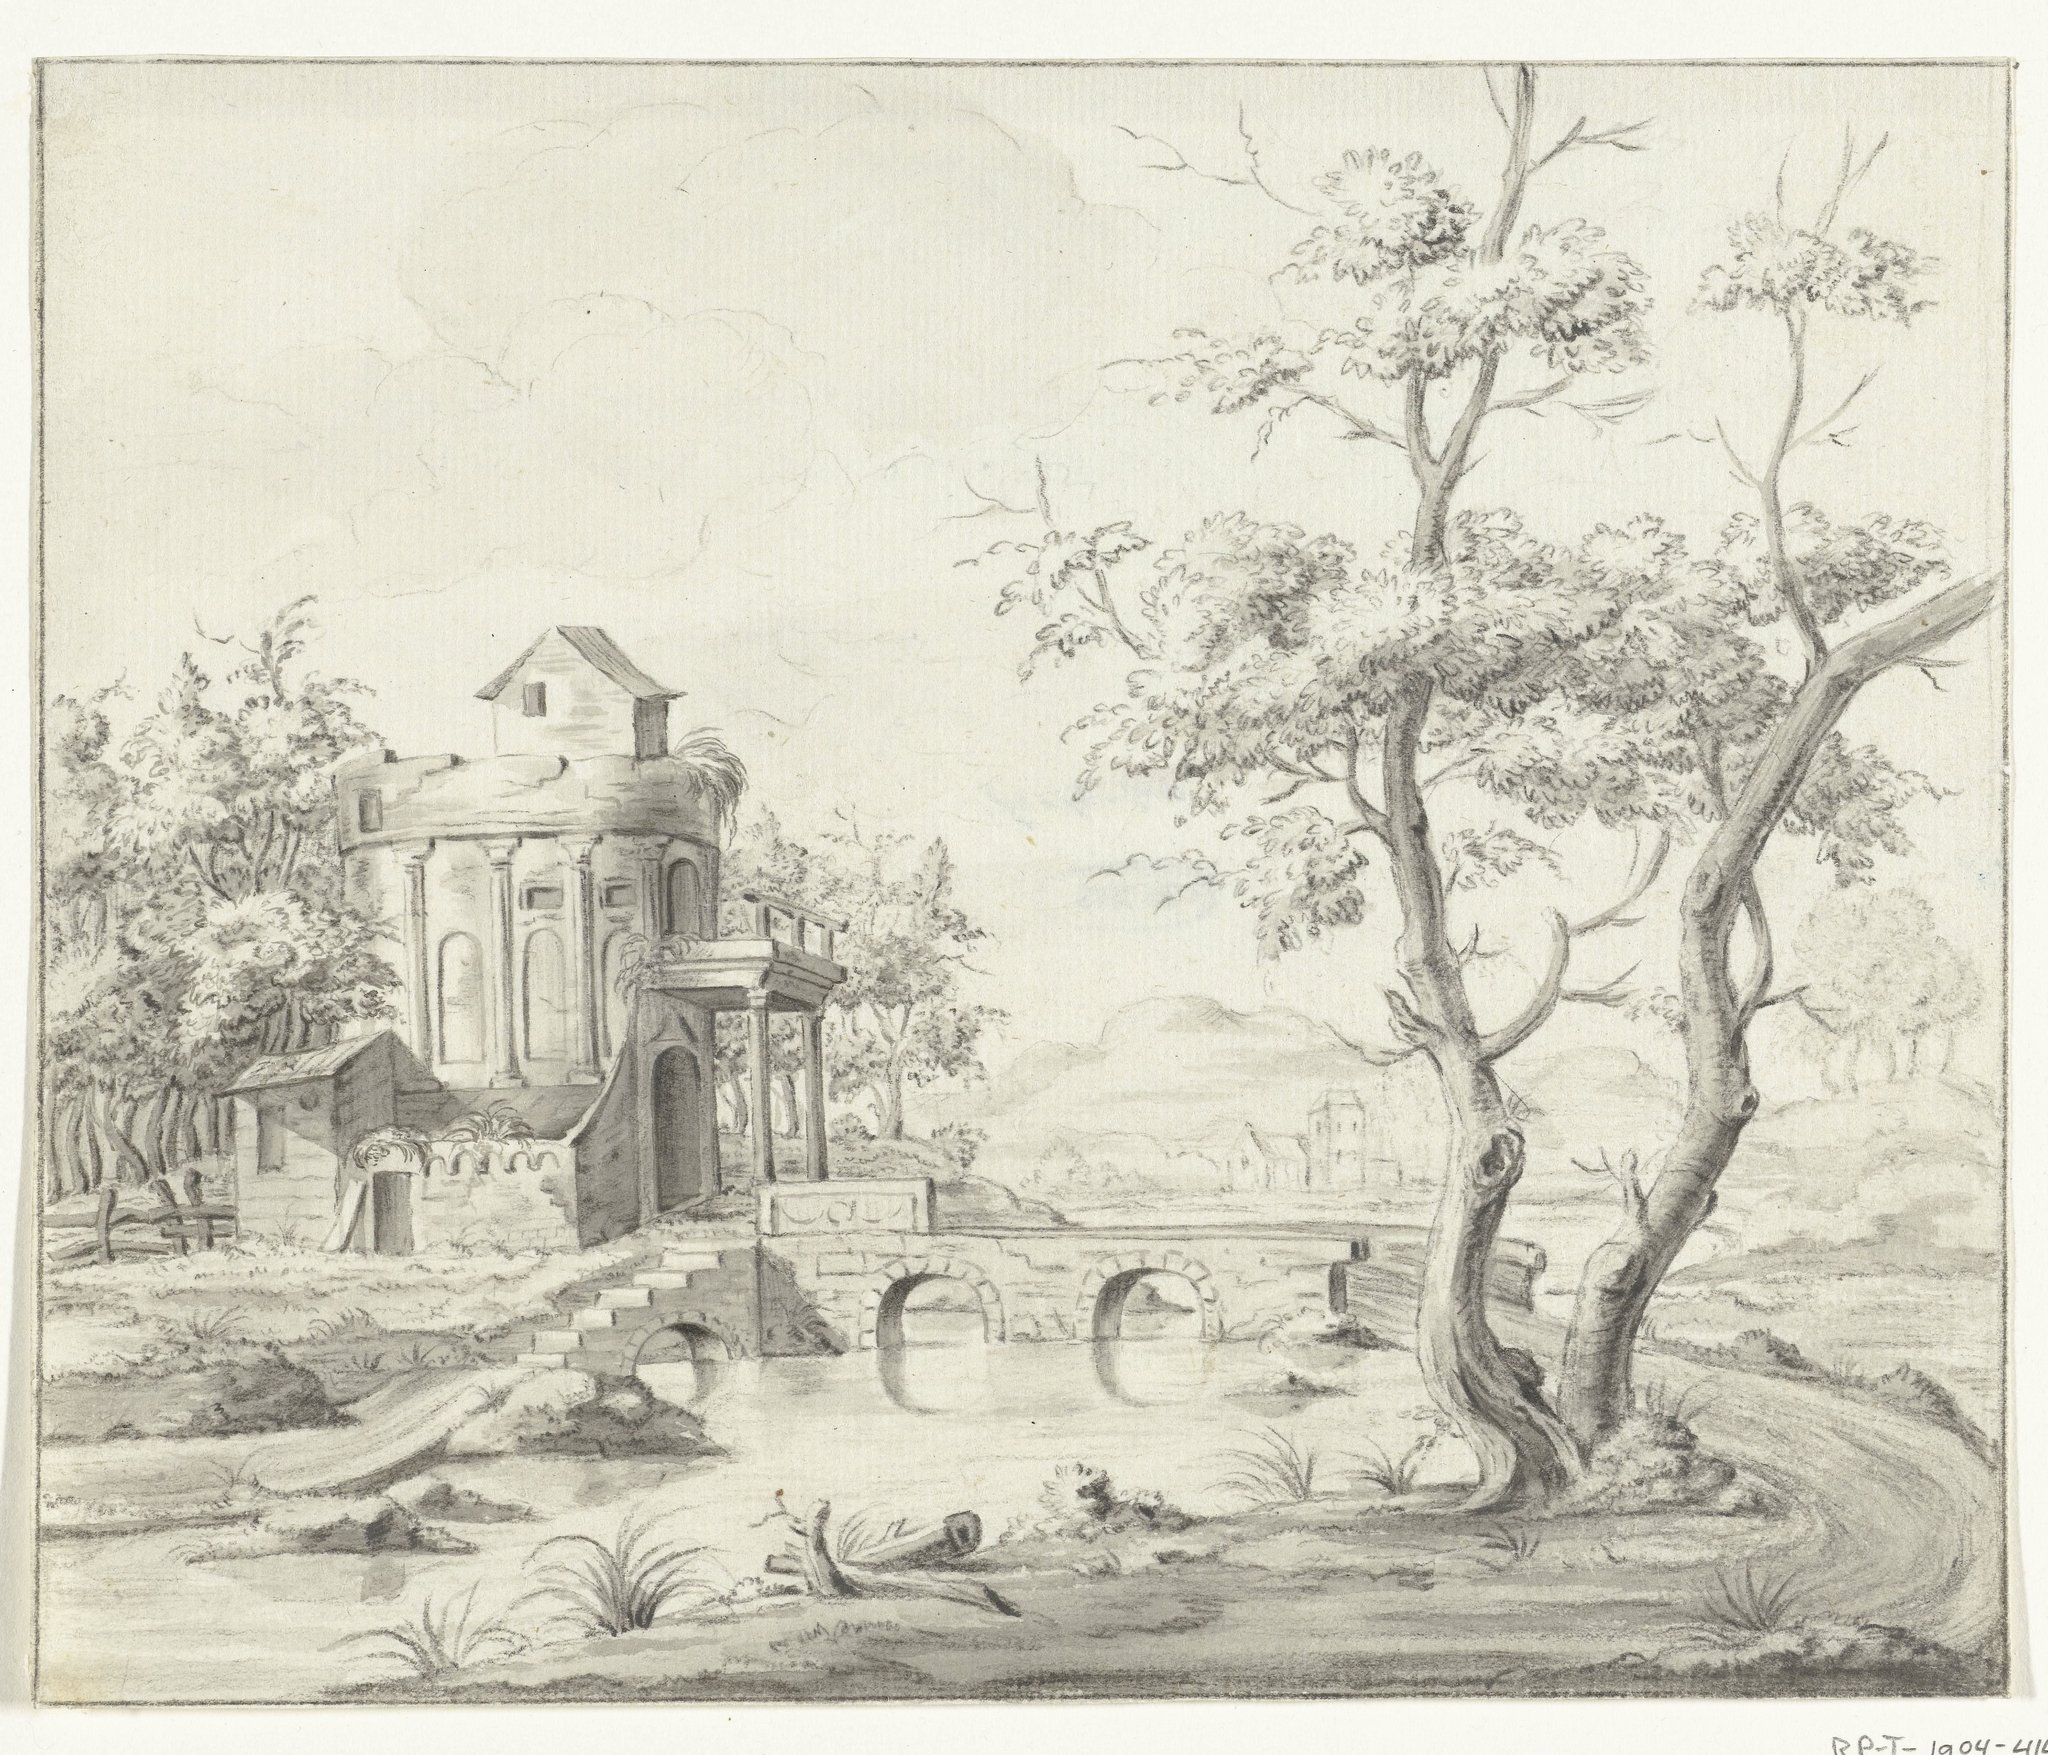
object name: drawing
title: Landschap met fantastische ruïne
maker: jean bernard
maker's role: draughtsman, print maker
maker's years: 1765-1833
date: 1775-1833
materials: chalk, ink, paper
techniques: brush, pen